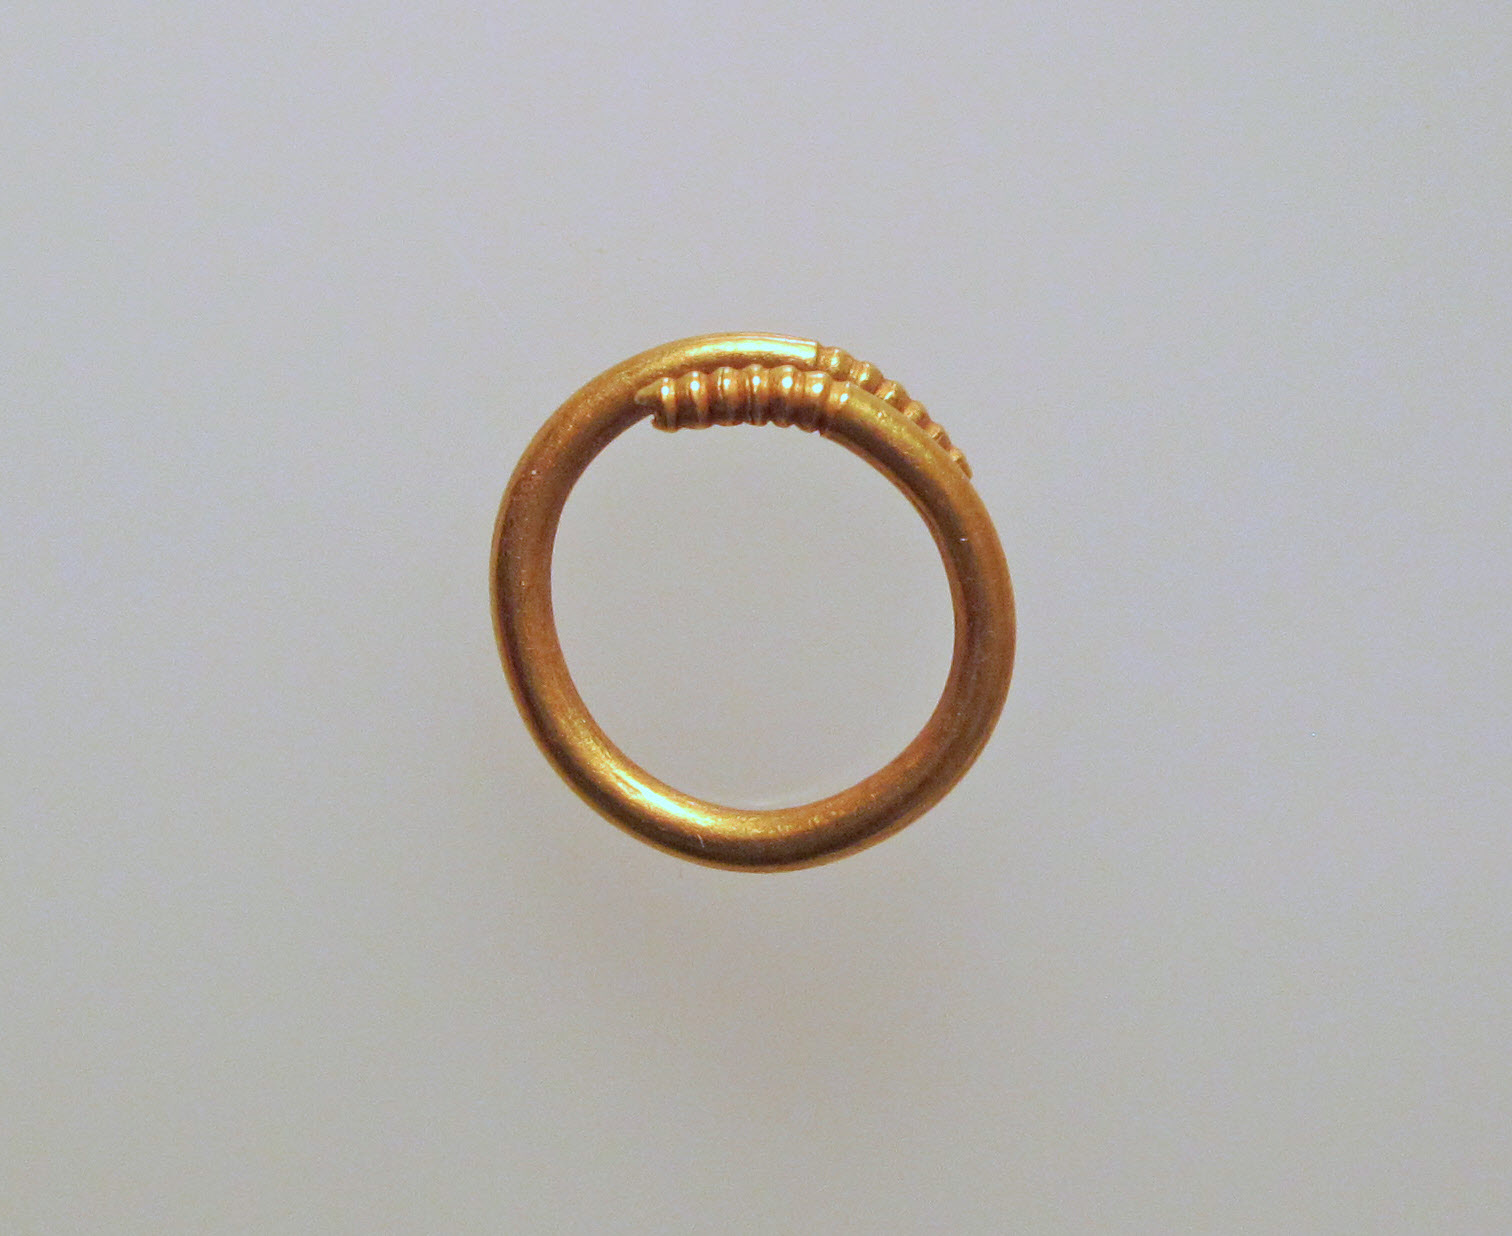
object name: spiral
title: Spirals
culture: cypriot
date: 3900 BCE-100 CE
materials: gold